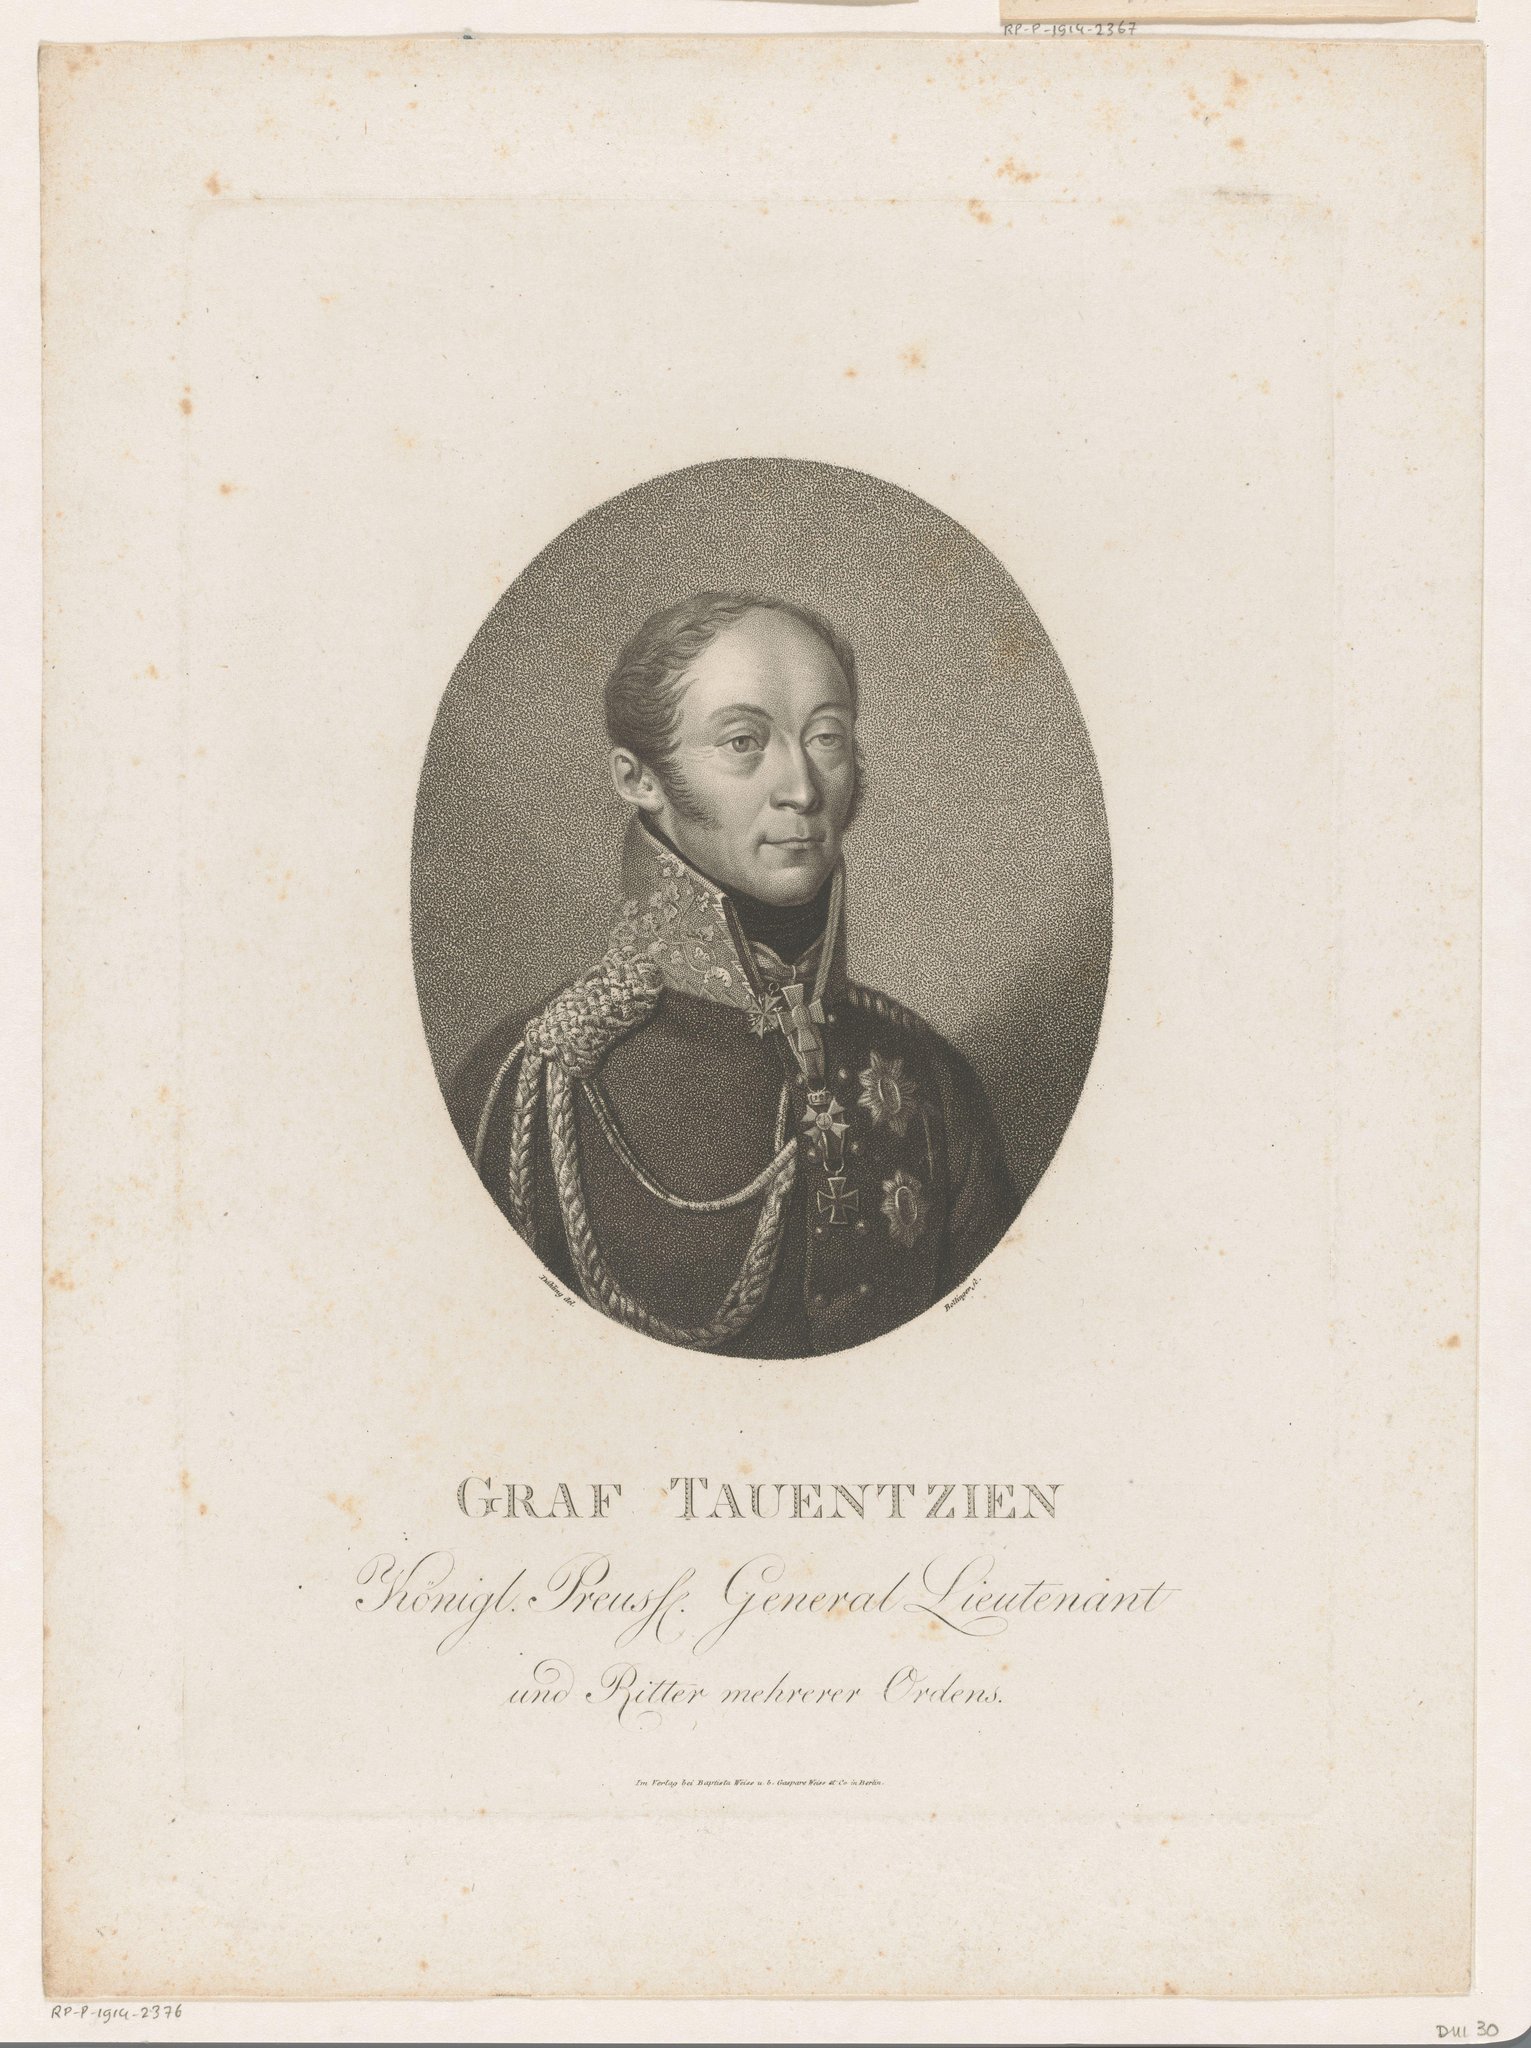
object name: print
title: Portret van Friedrich Bogislav Emanuel, Graf Tauentzien von Wittenberg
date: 1813-1825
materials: paper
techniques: stippling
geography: berlin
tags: berlin, knighthood order (with name) - insignia of a knighthood order, e.g.: badge, chain (with name of order), knighthood order, historical persons, (military) uniforms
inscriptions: collector's mark: Lugt 2228